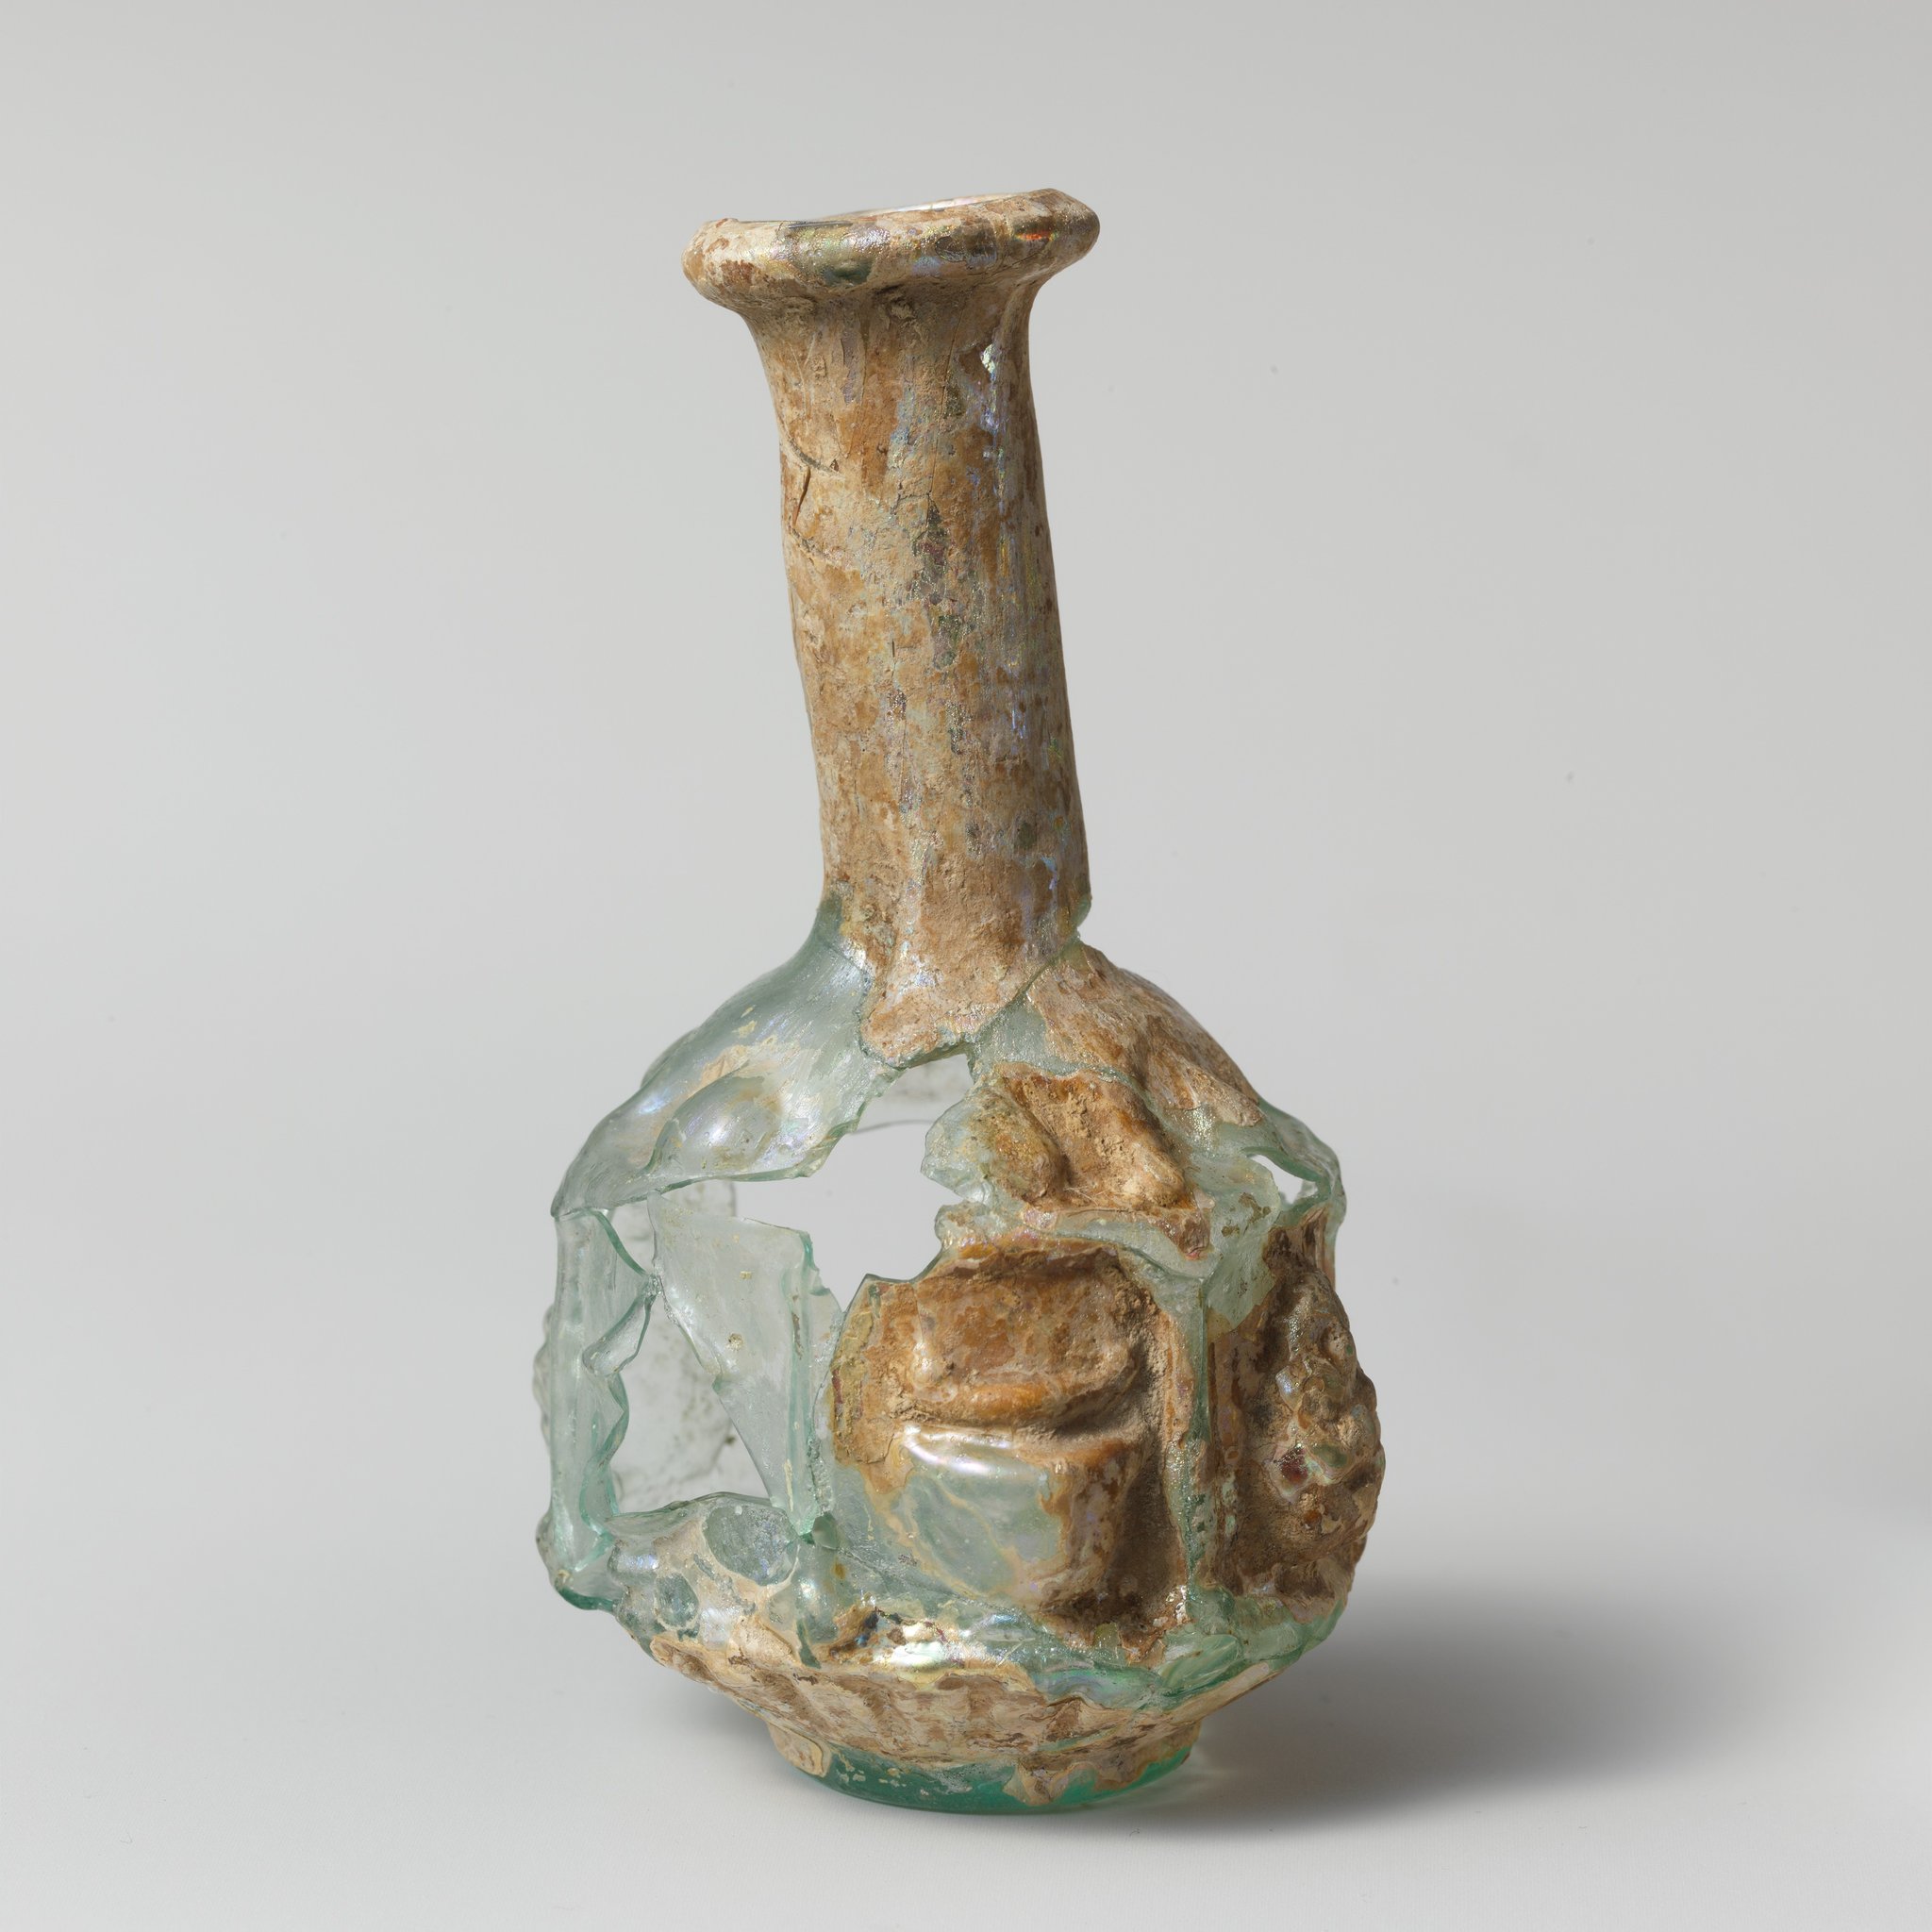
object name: bottle, hexagonal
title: Glass hexagonal bottle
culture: roman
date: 1-50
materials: glass